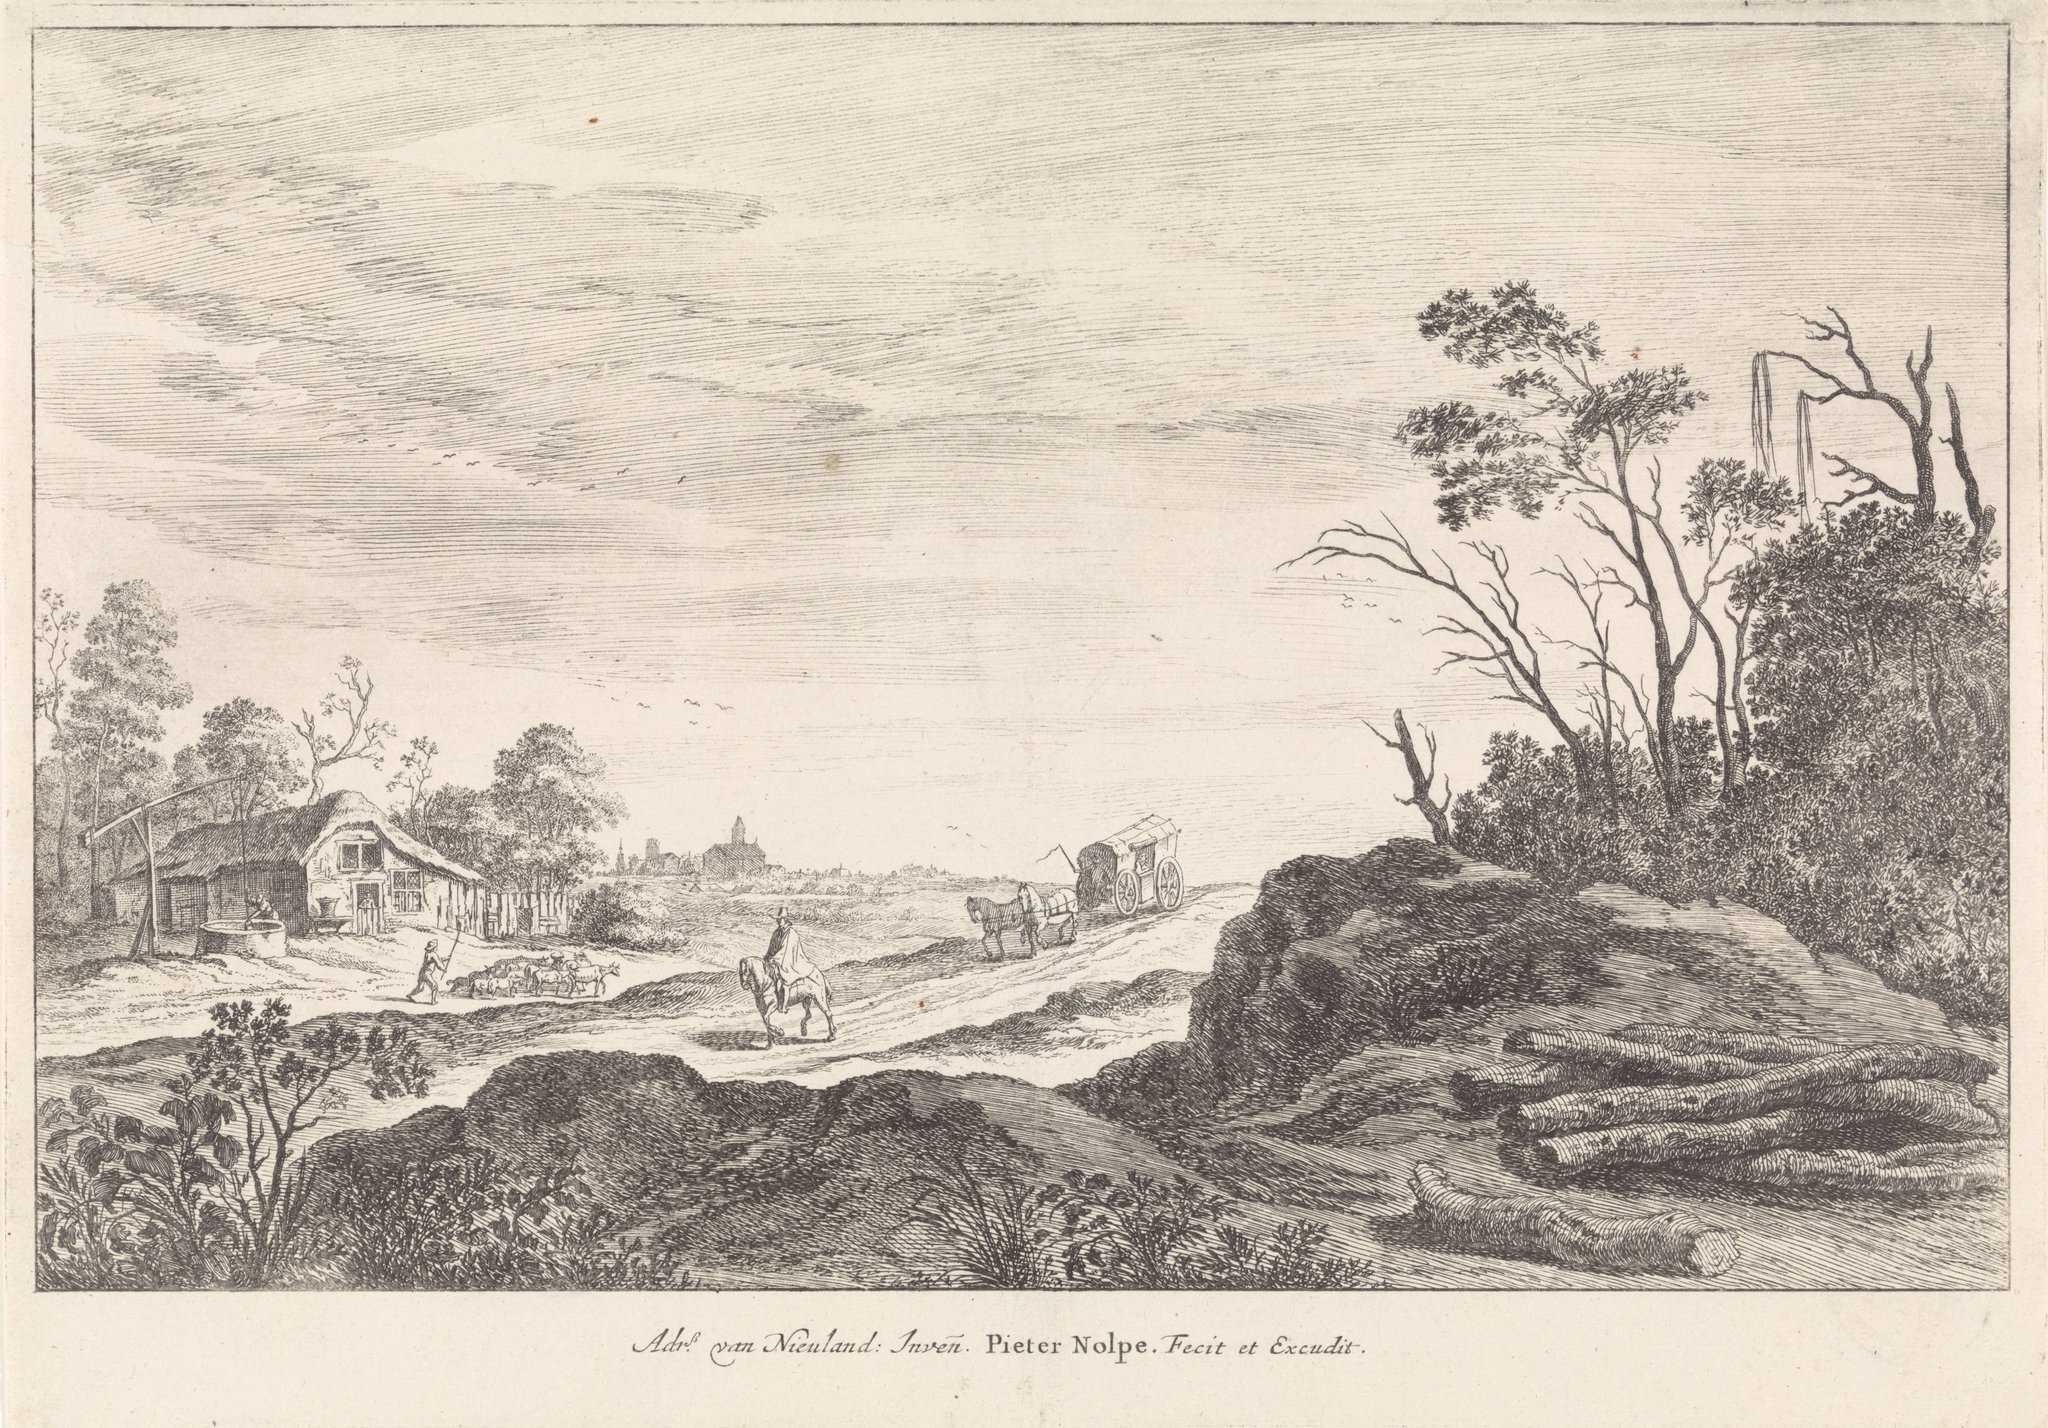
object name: print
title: Landschappen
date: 1623-1653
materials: paper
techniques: engraving, etching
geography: amsterdam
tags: riding a horse, ass, or mule; rider, horseman, well, road, path, farm or solitary house in landscape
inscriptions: collector's mark: Lugt 240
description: Op een weg rijden een ruiter en een koets, die door twee paarden wordt getrokken. Links een boerderij, waarvoor een man water put en een boer met zijn vee loopt. Prent uit een serie landschappen.